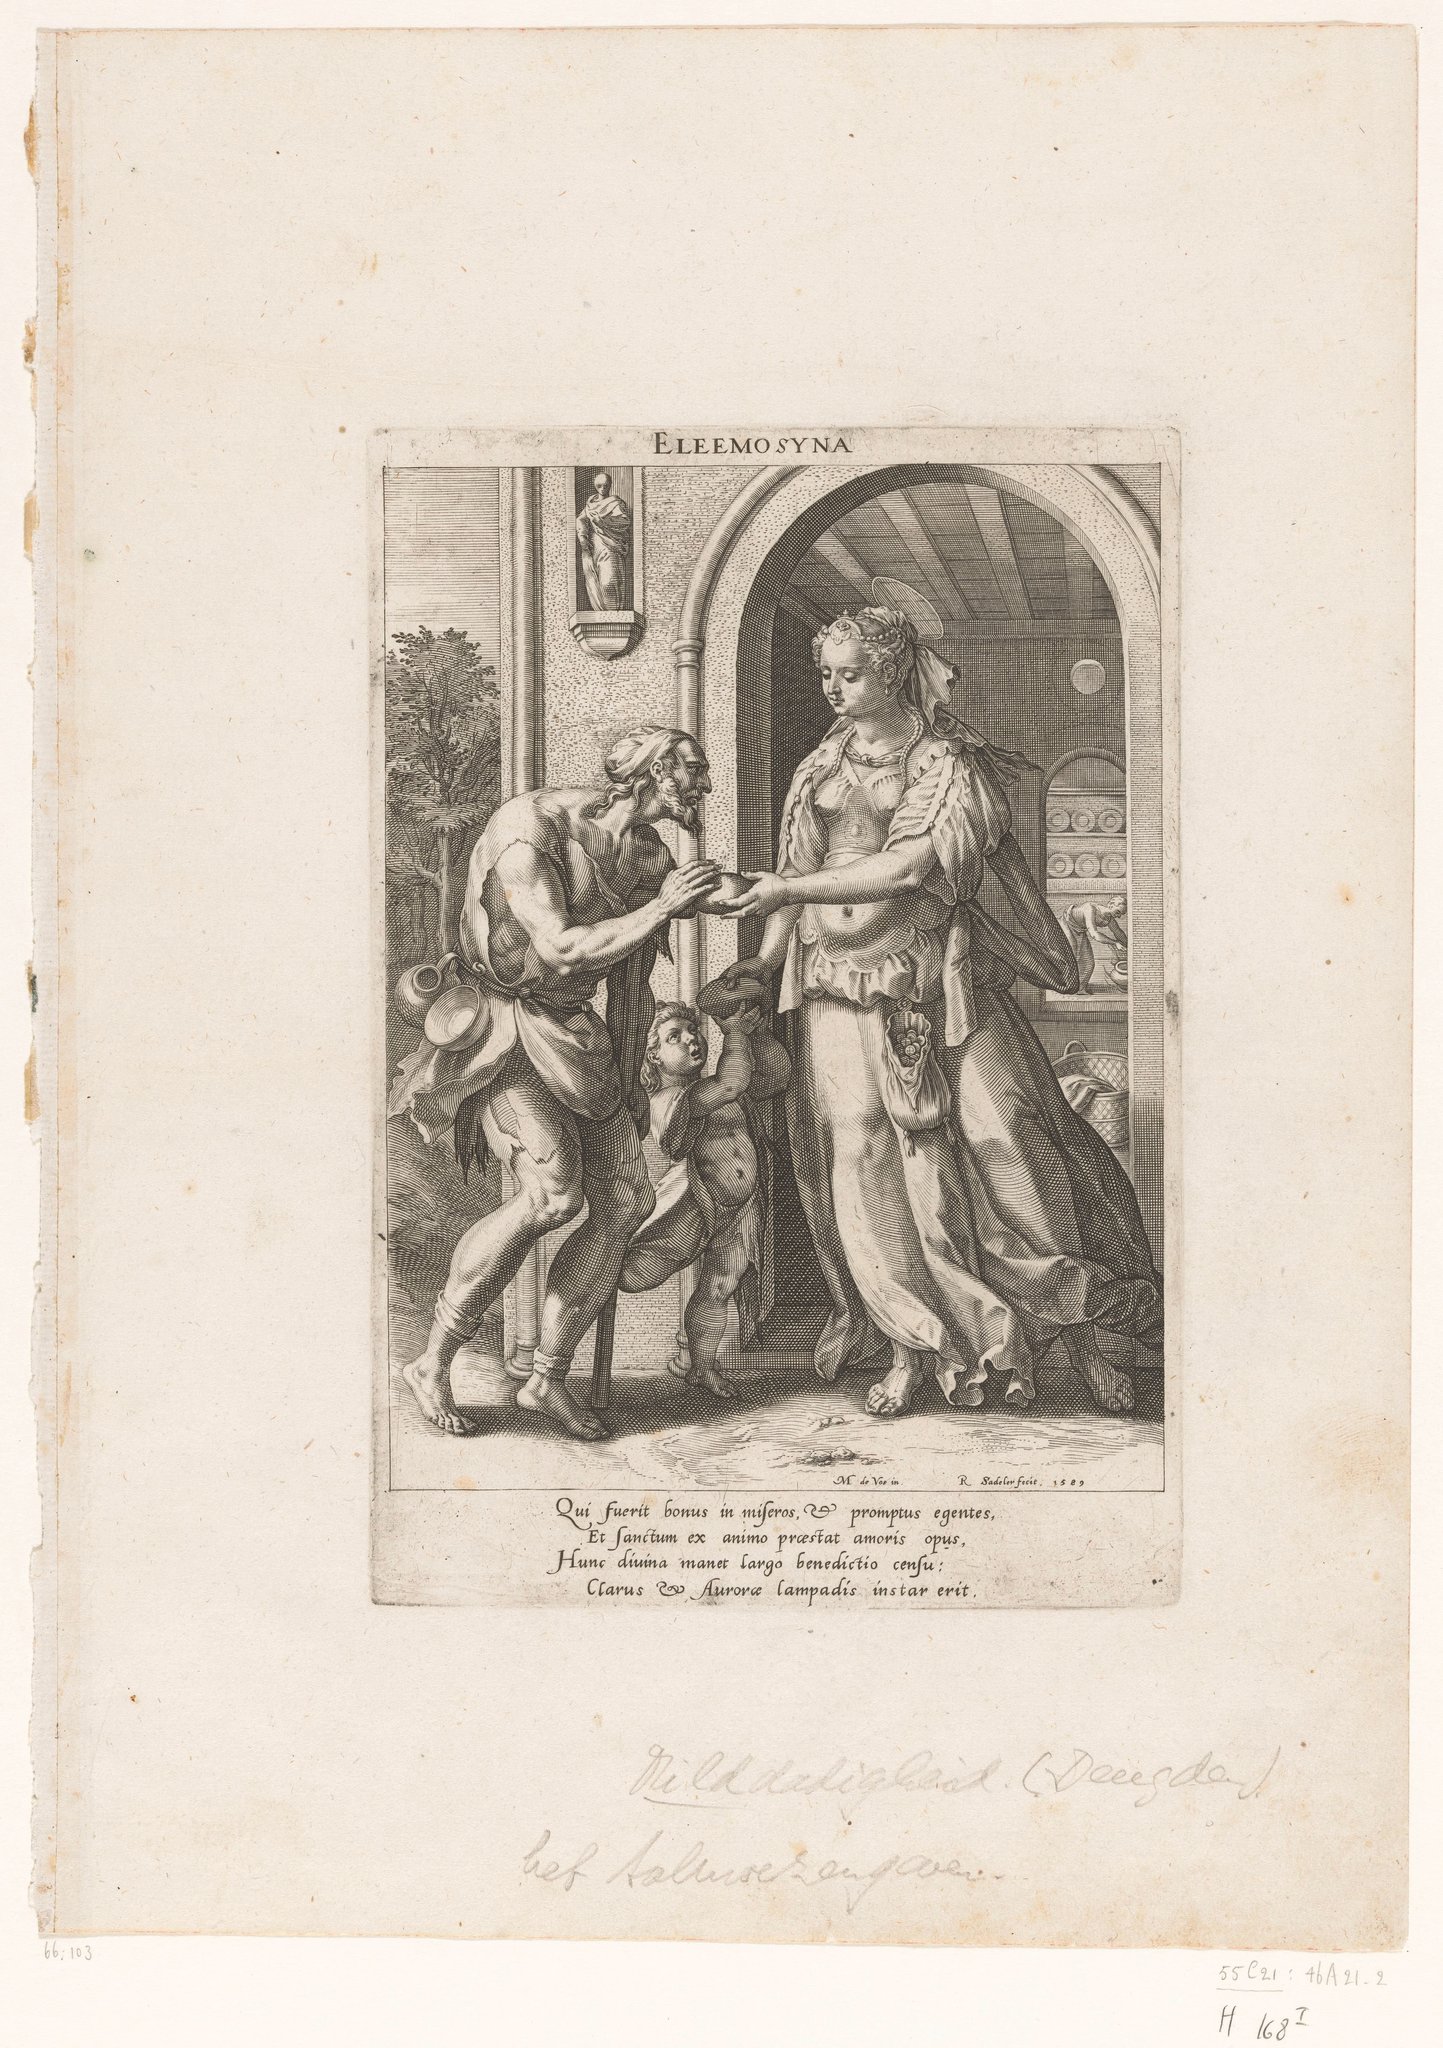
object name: print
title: Zes christelijke deugden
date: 1589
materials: paper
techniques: engraving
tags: giving alms or other charity, e.g.: handing out food, disabilities, deformations, beggar, generosity, liberality; 'generosità', 'liberalità' (ripa), 'elemosina' (ripa)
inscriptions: collector's mark: Lugt 2228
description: De vrouwelijke personificatie van Liefdadigheid (Elemosina). Ze staat voor een deuropening en geeft twee broden aan twee bedelaars: een kind en een man steunend op een okselkruk. De vierde prent uit een serie met als onderwerp zes christelijke deugden.